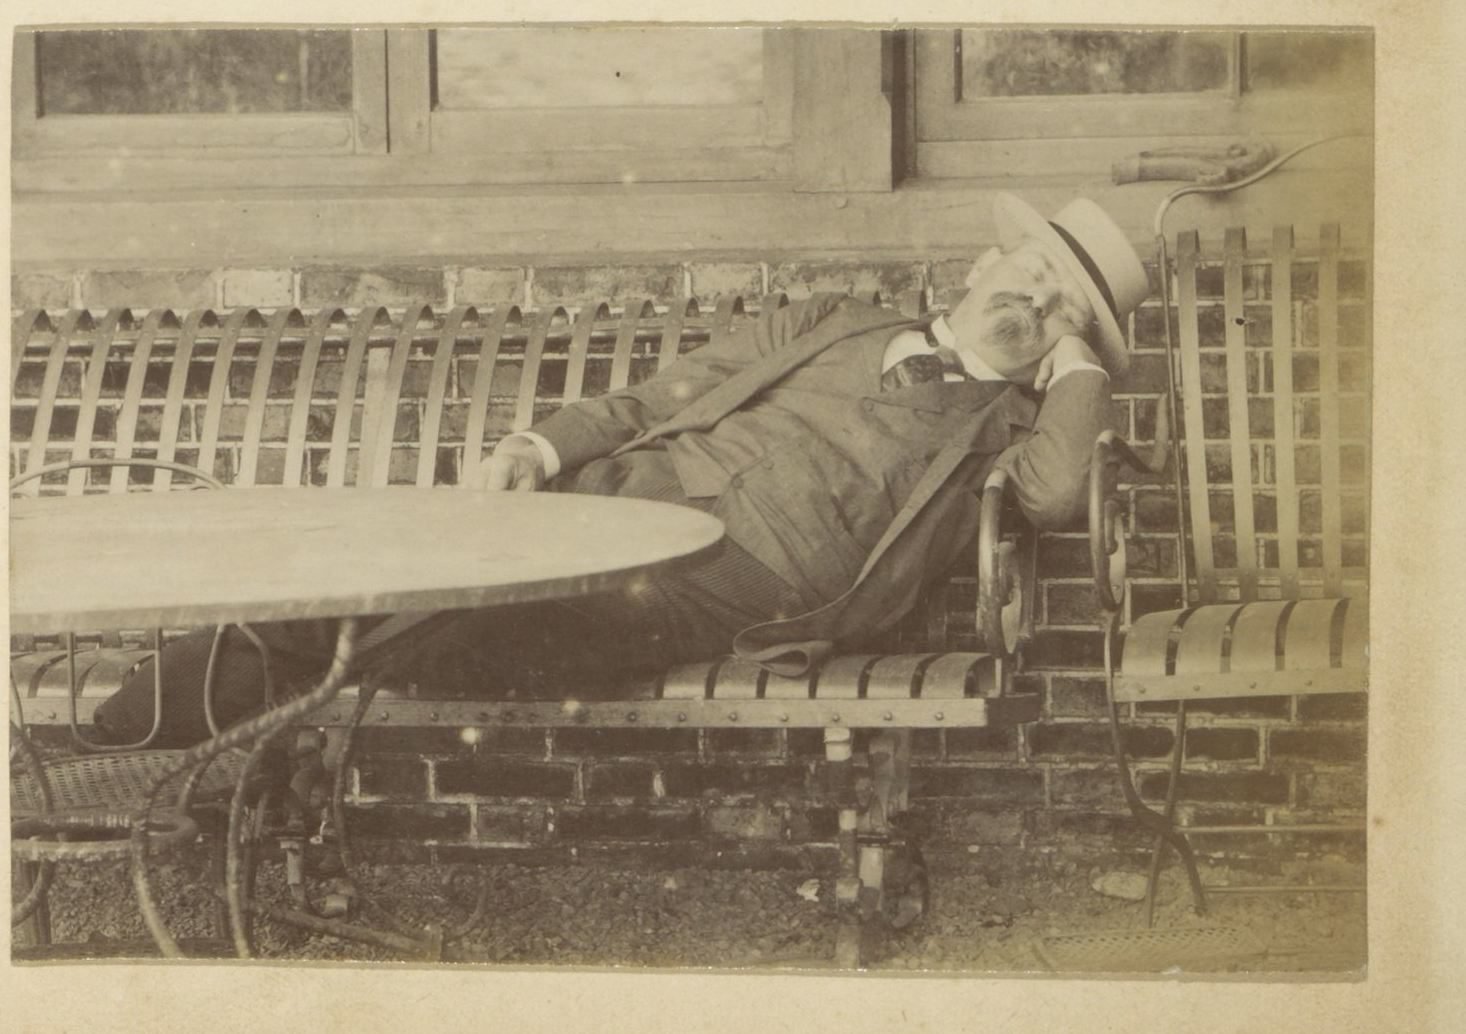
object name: photograph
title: Portret van een Franse man slapend op een bank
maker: Anonymous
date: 1900-1910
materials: paper, photographic support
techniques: albumen print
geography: france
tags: adult man, head-gear: hat, sleeping; unconsciousness, france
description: Onderdeel van Fotoalbum van een Franse amateurfotograaf met opnames van een familie, distilleerderij Delizy & Doistau Fils, het leger en bezienswaardigheden in Frankrijk.